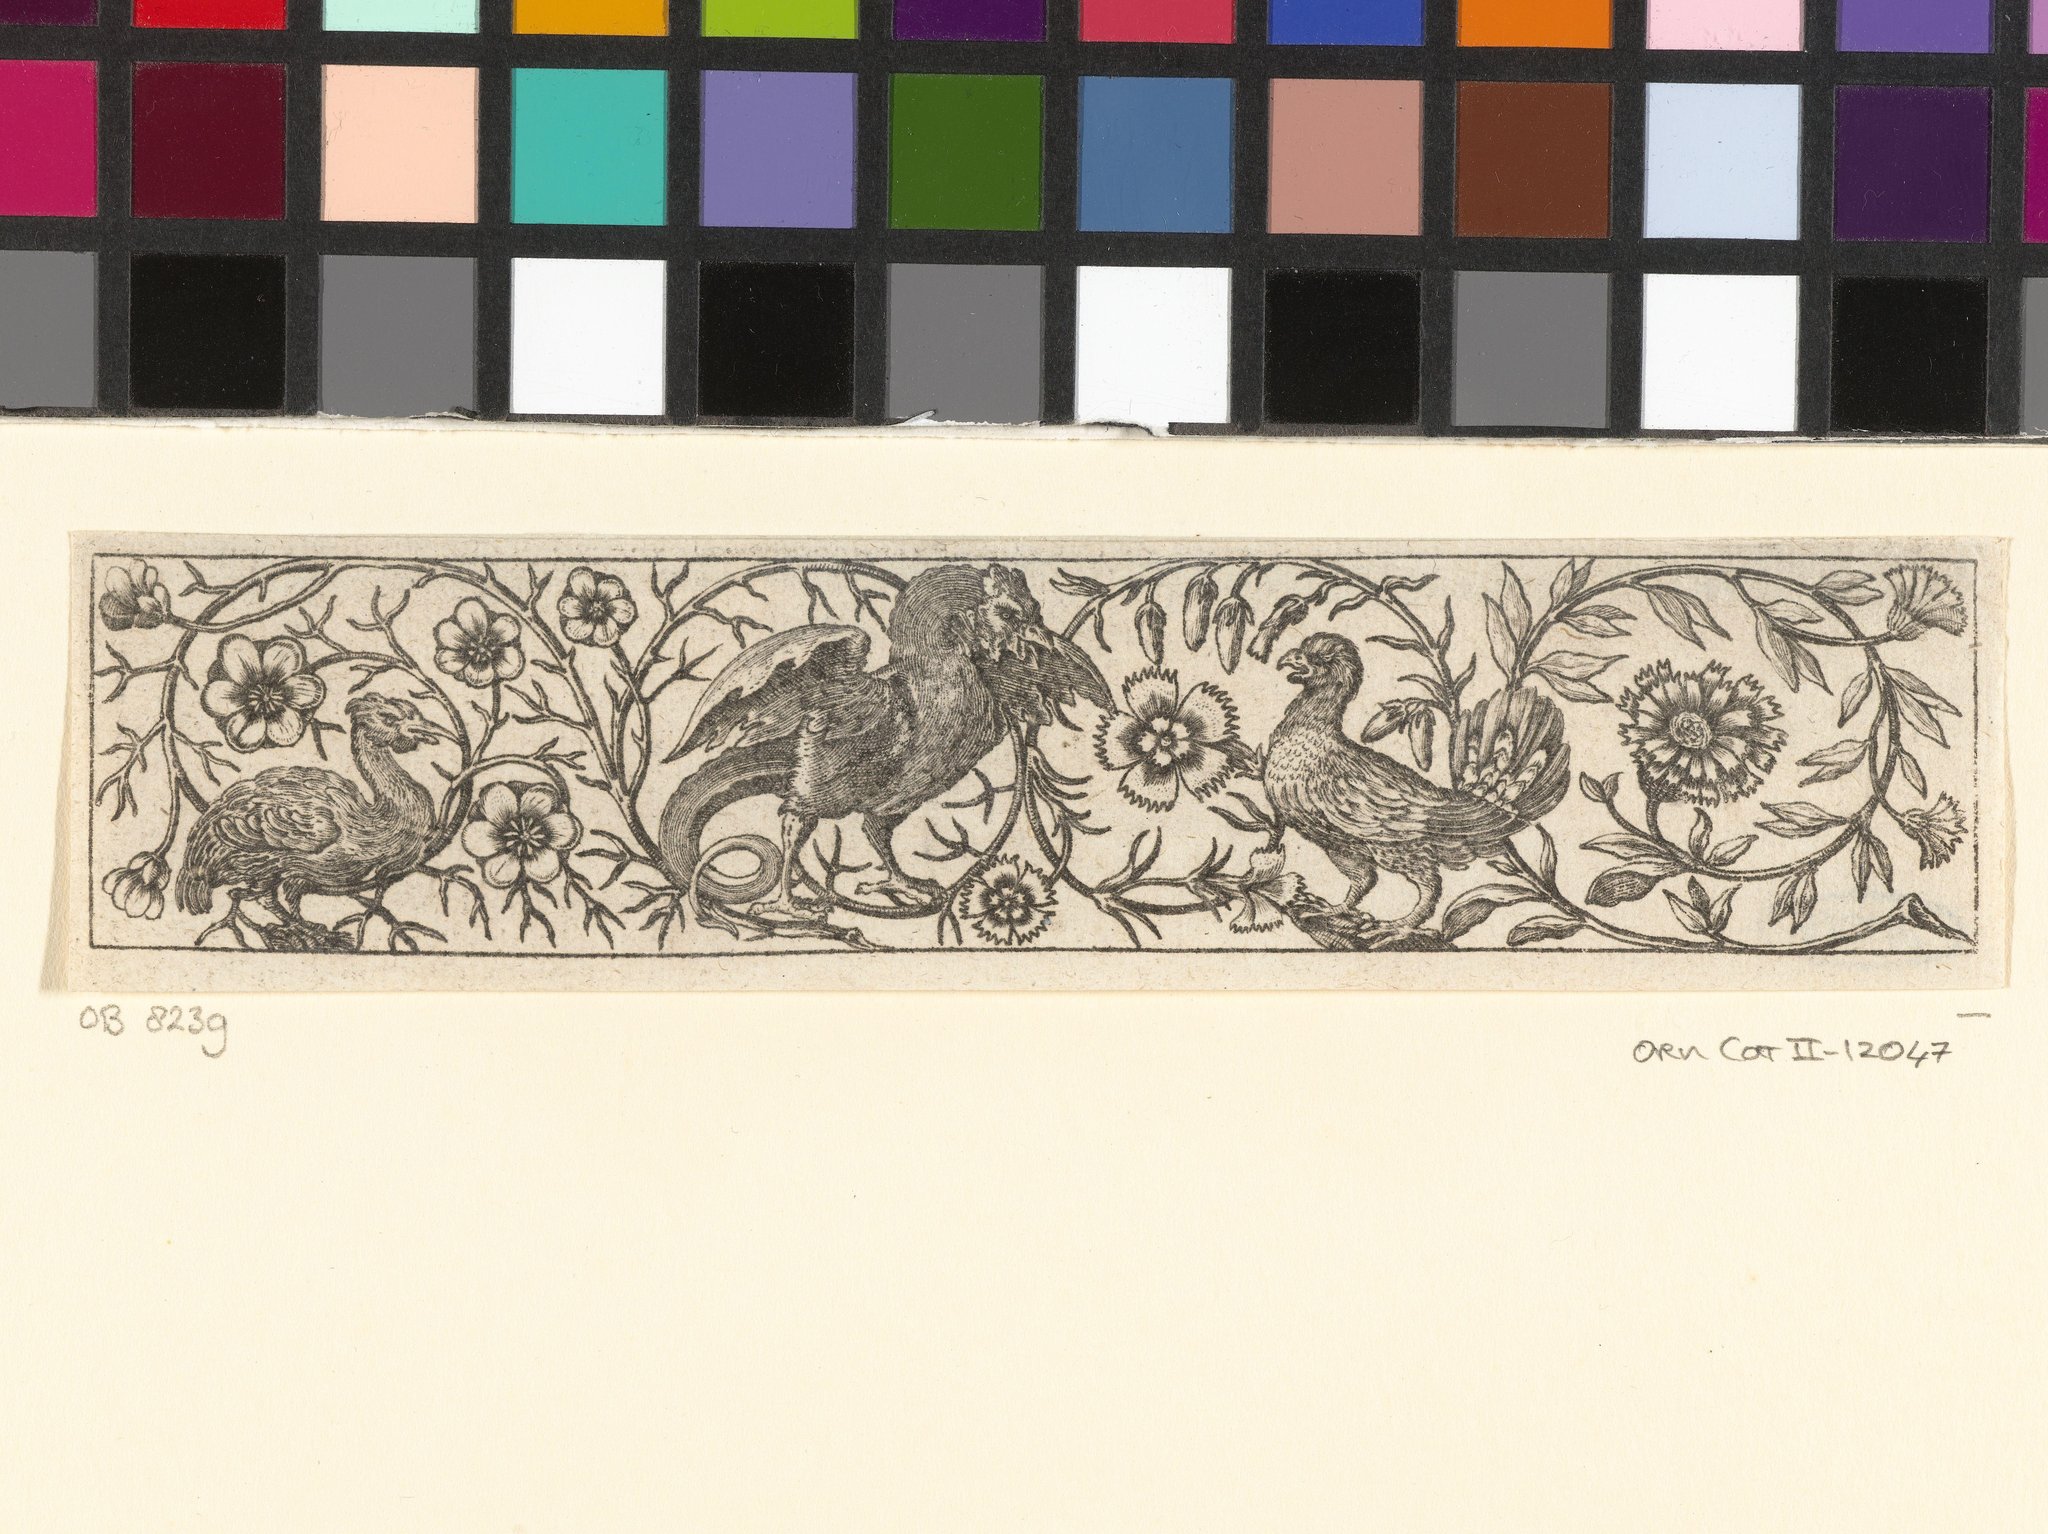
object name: print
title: Fries met bloemenranken en drie vogels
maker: Anonymous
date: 1600-1699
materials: paper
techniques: etching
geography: germany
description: De middelste vogel is een haan met een slangenstaart en gespreide vleugels.